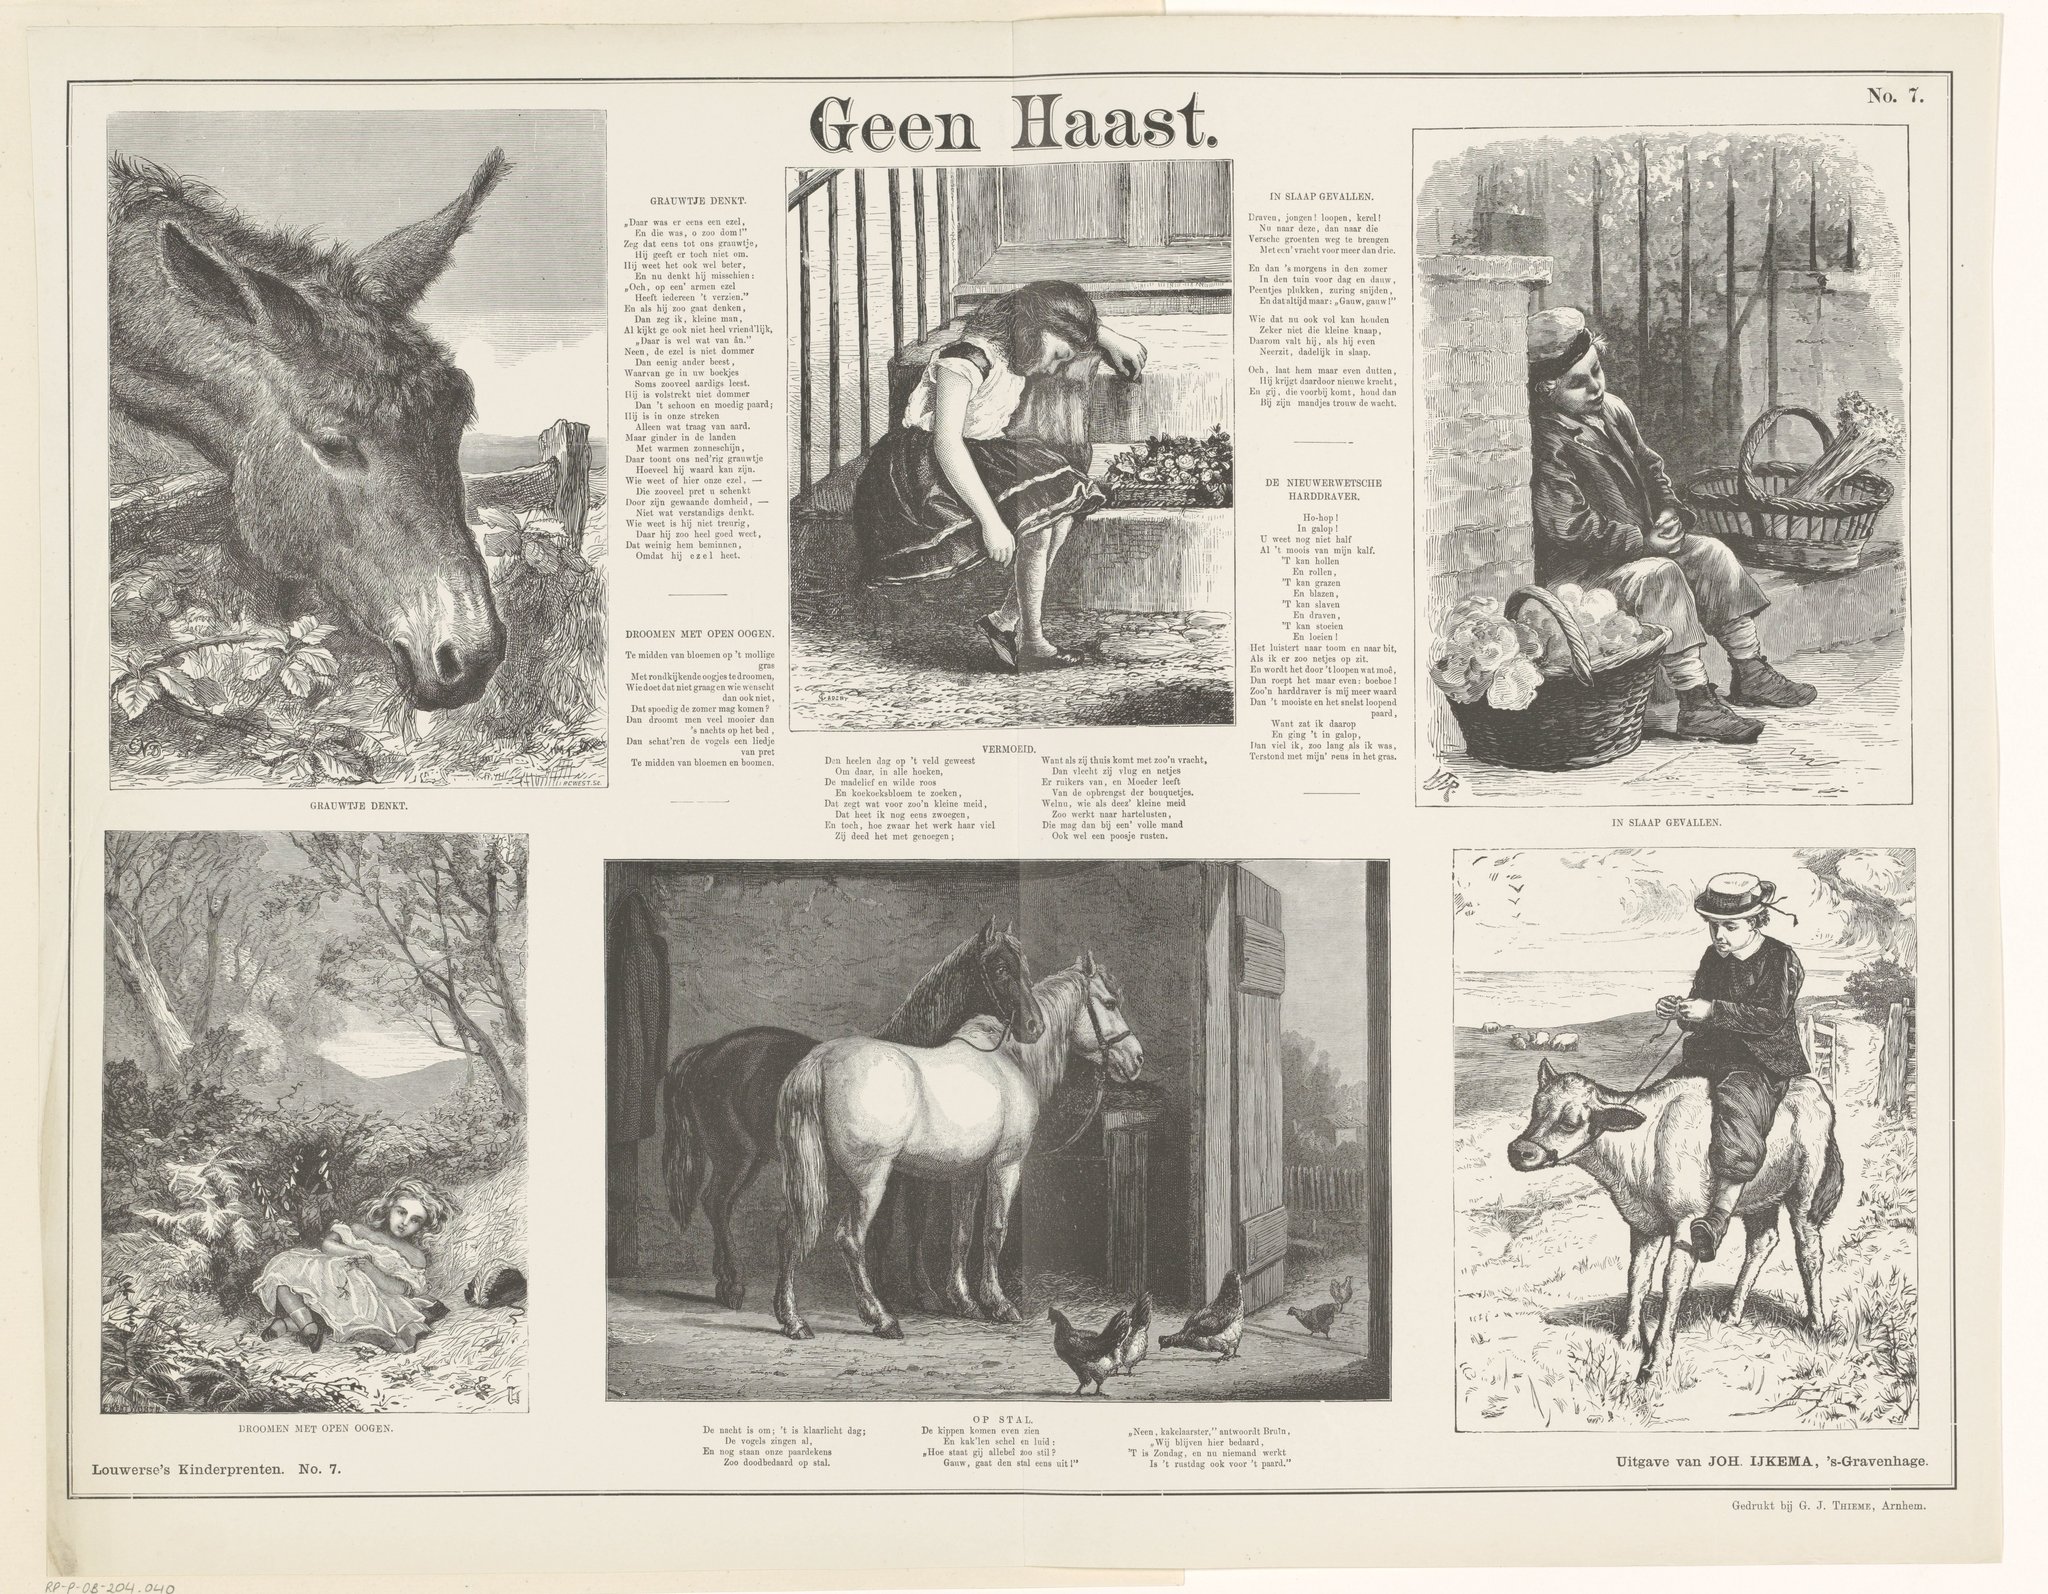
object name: print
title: Groote haast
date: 1882-1905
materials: paper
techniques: letterpress printing, printing block, engraving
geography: the hague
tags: ass, donkey, child, horse, stall, stable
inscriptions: collector's mark: Lugt 2760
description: Blad met 6 voorstellingen van verschillende aard, waaronder voorstellingen van een ezel, een slaperig meisje op een trap en twee paarden in een stal. Tussen de afbeeldingen versjes in boekdruk. Genummerd rechtsboven en linksonder: No. 7.